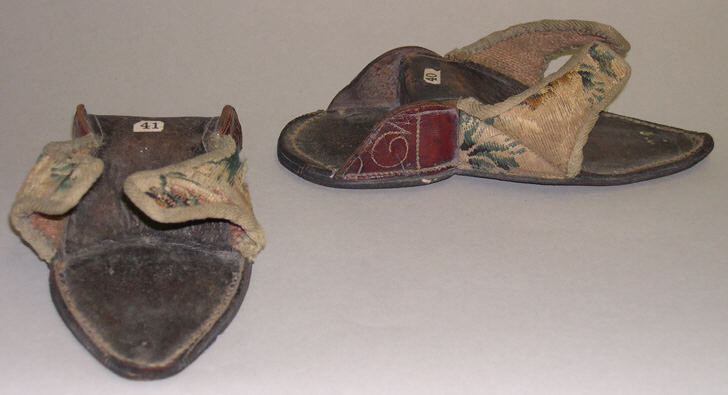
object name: clog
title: Clogs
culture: british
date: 1730-1740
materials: leather, silk, wool